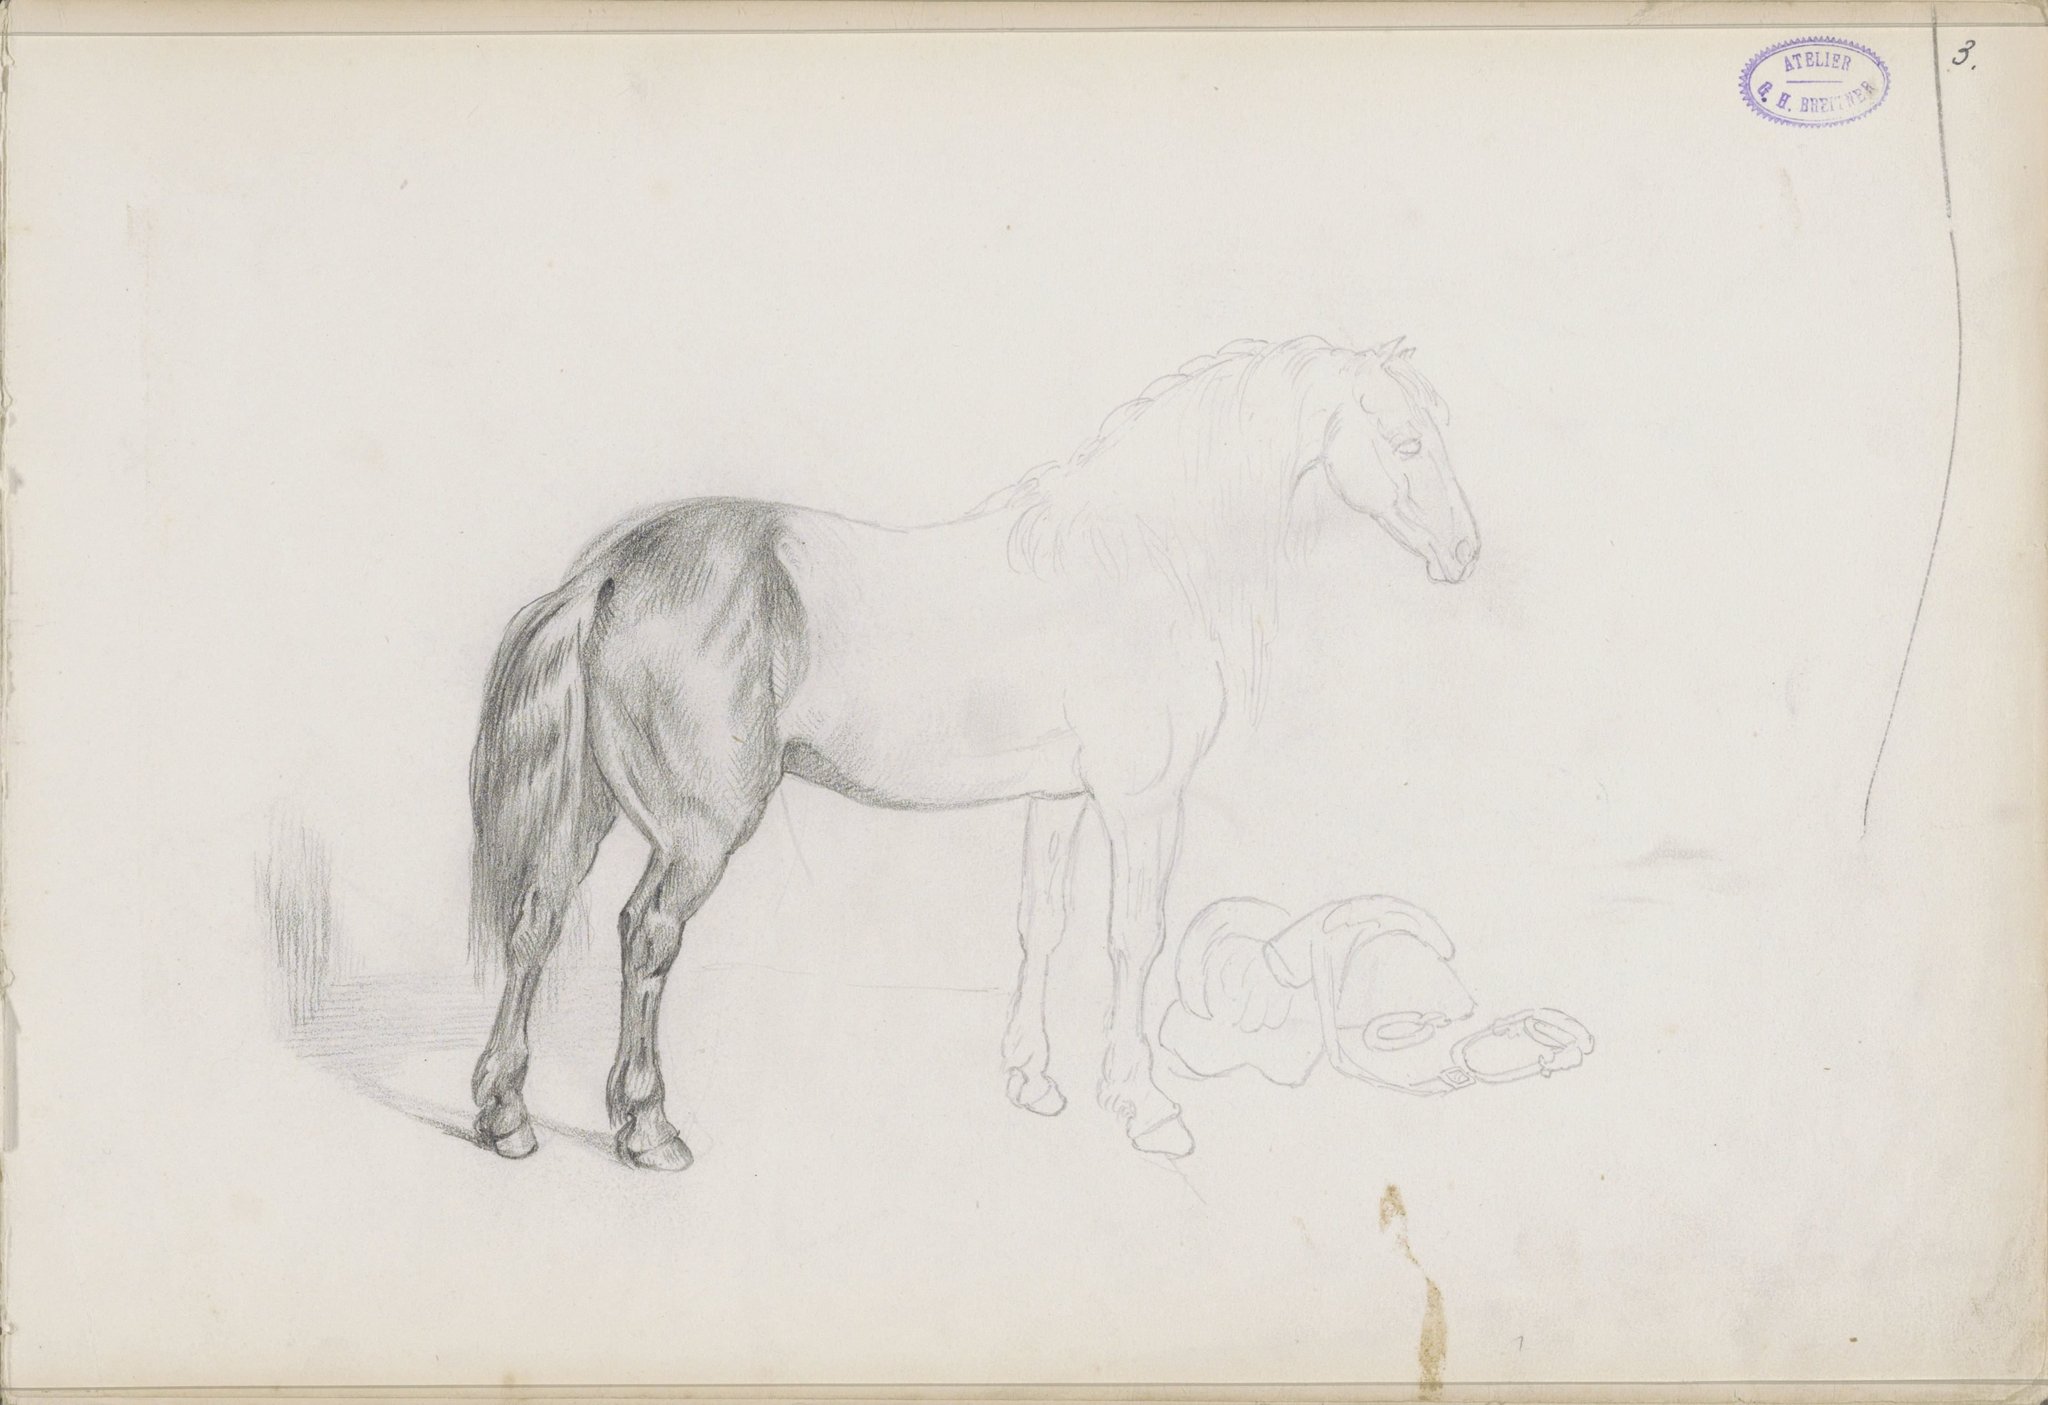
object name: sketchbook leaf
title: Staand paard en een zadel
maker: george hendrik breitner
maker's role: draughtsman, painter, print maker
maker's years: 1857-1923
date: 1809-1872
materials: paper, pencil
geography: rotterdam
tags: saddle, horse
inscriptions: workshop stamp: Lugt 291d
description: Blad 3 uit een schetsboek met 32 bladen.